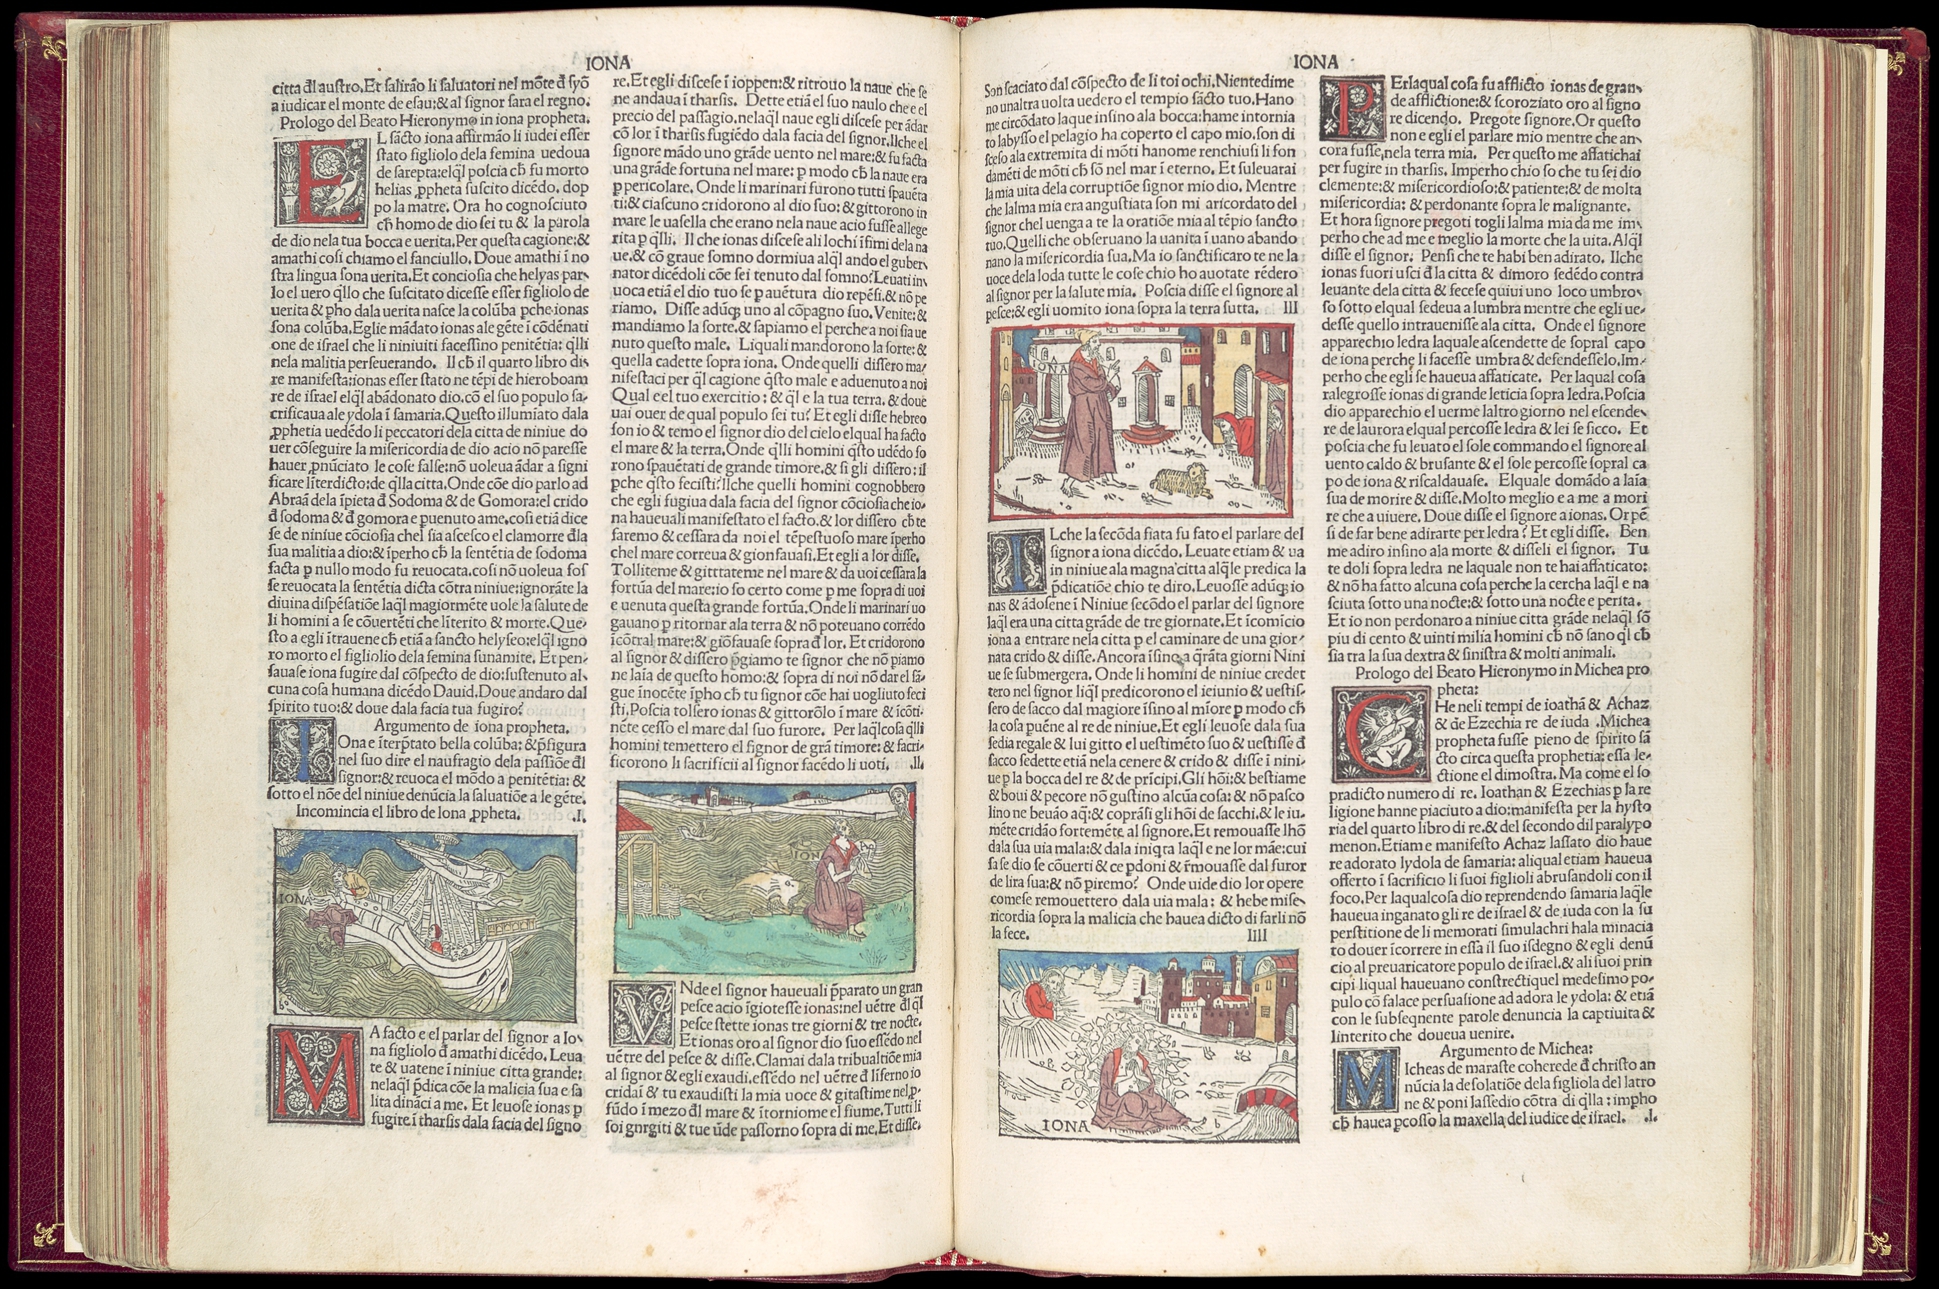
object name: book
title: The Malermi Bible, vol. II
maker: niccolò malèrmi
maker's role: translator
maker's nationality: italian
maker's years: 1415-1481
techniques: hand coloring, printing, woodcut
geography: italy